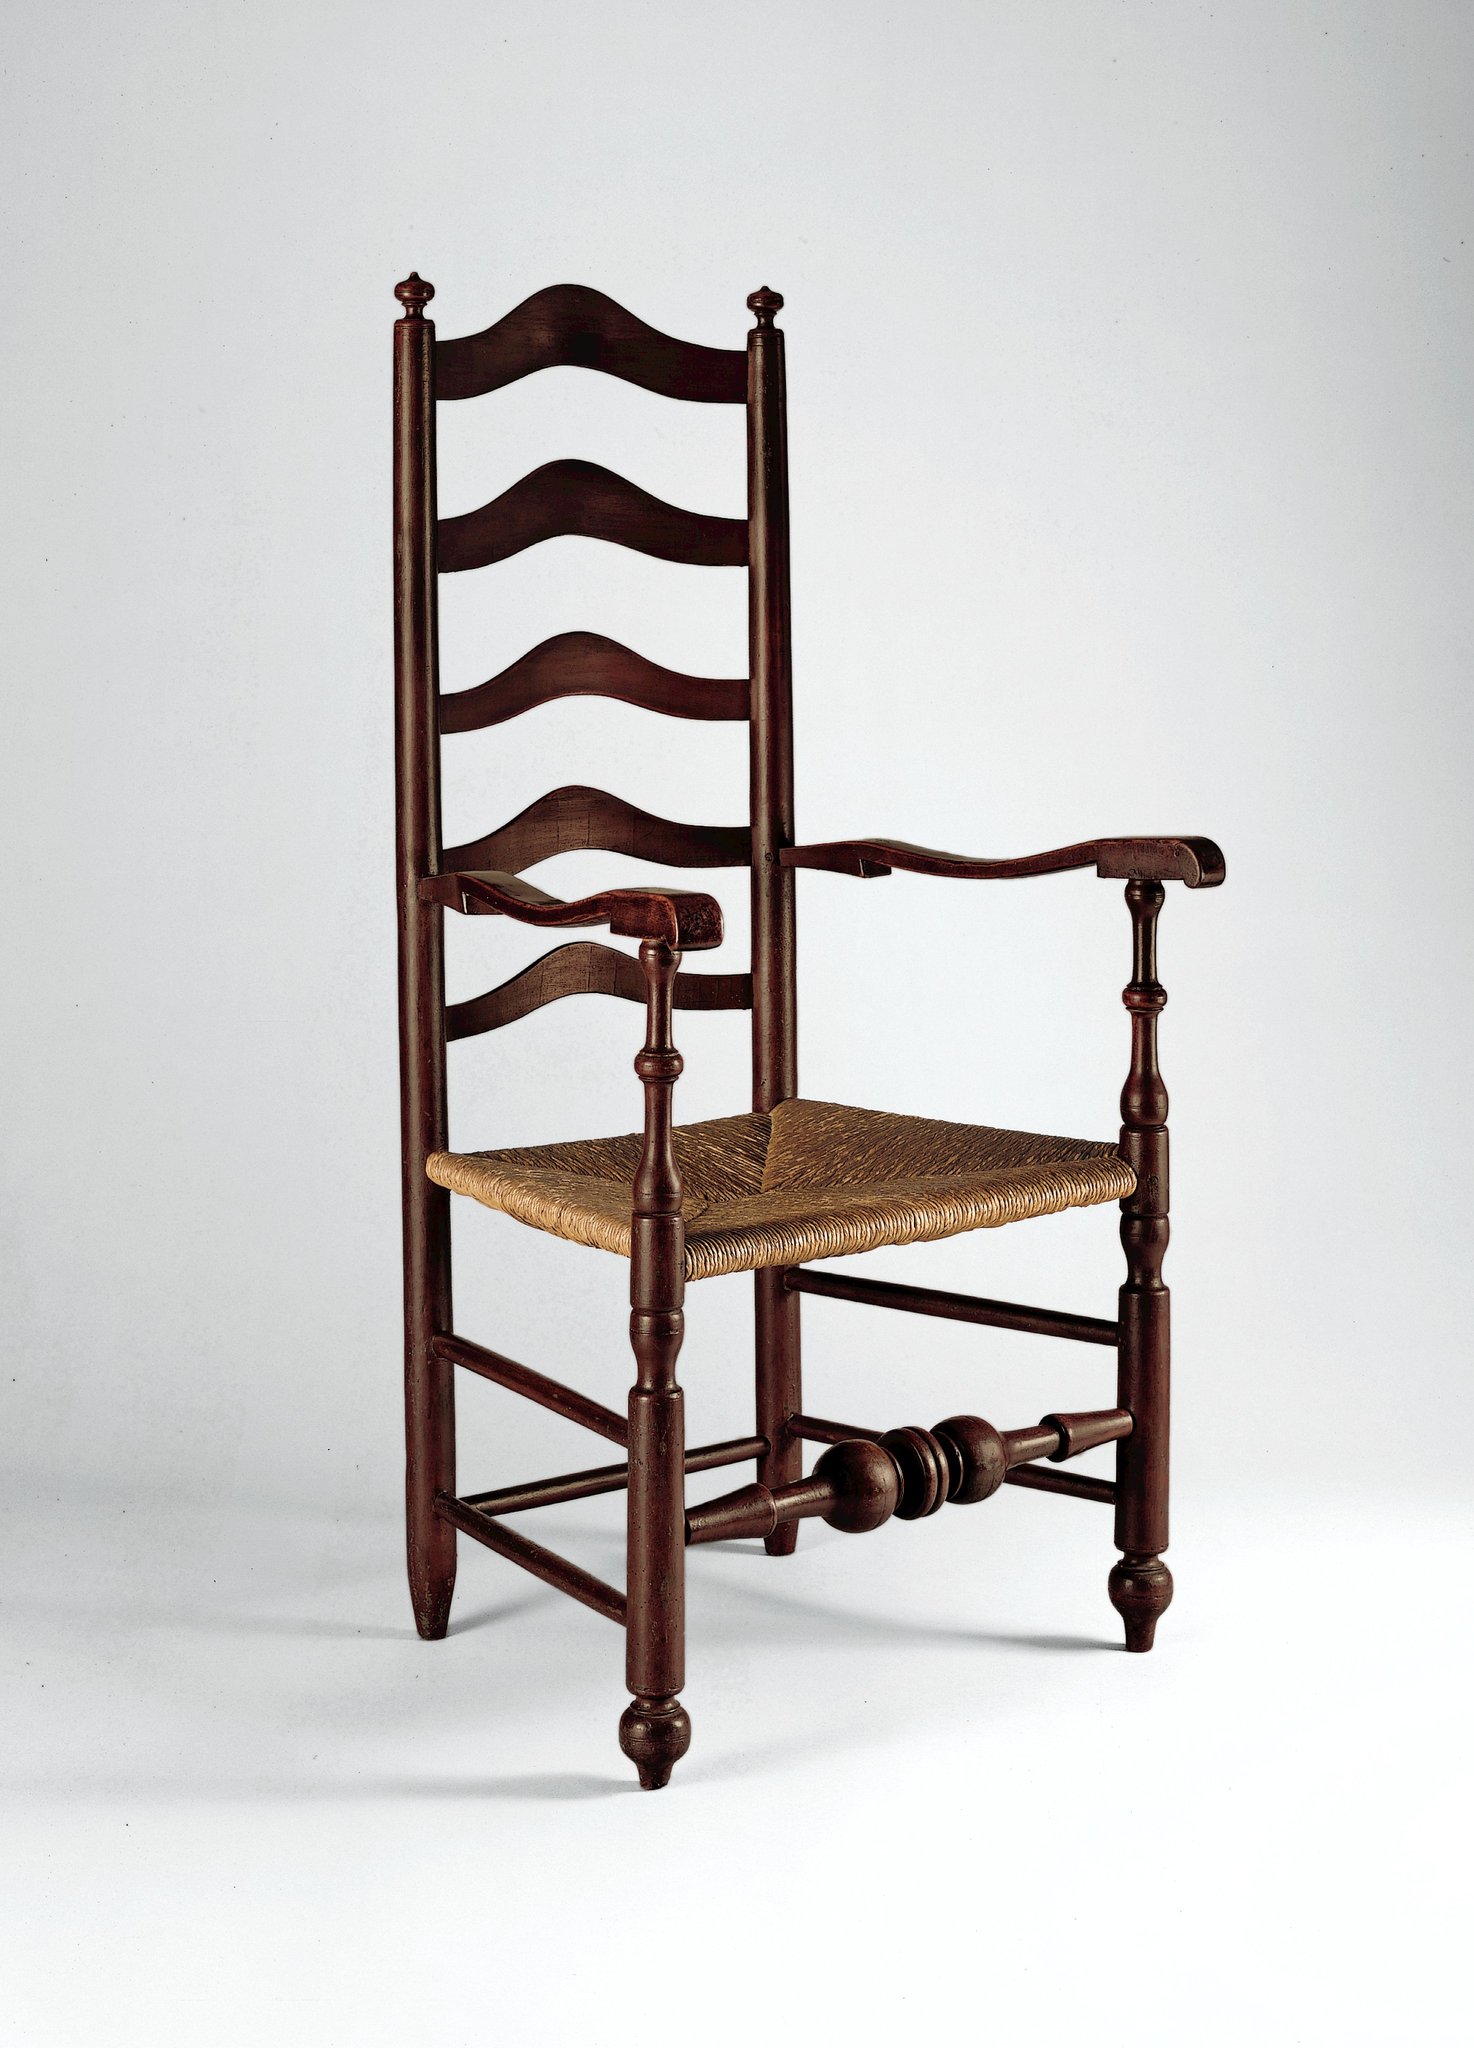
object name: armchair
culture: american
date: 1730-1780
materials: wood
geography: united states